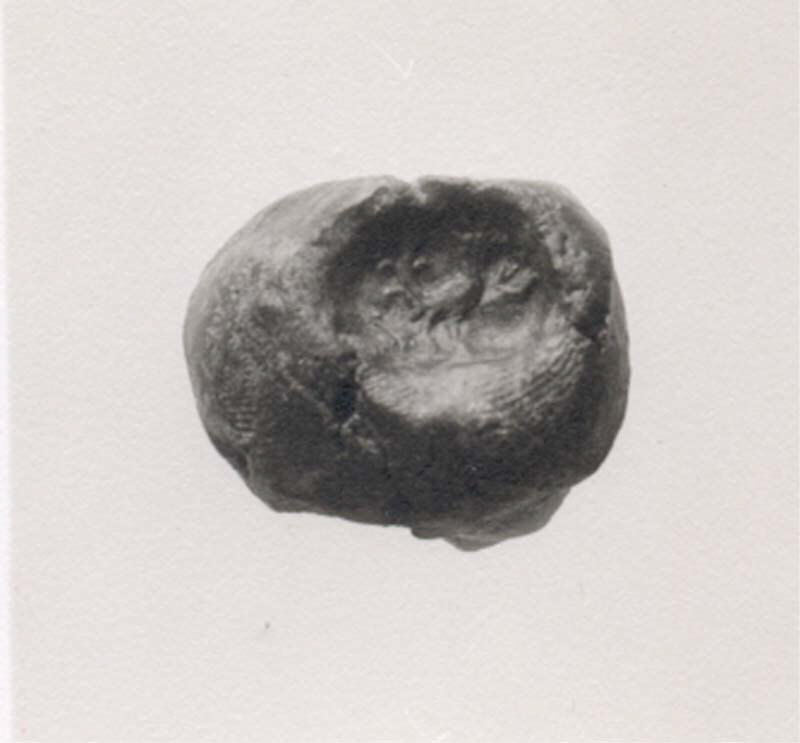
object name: sealing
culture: sasanian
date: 601-700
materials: clay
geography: iran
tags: birds